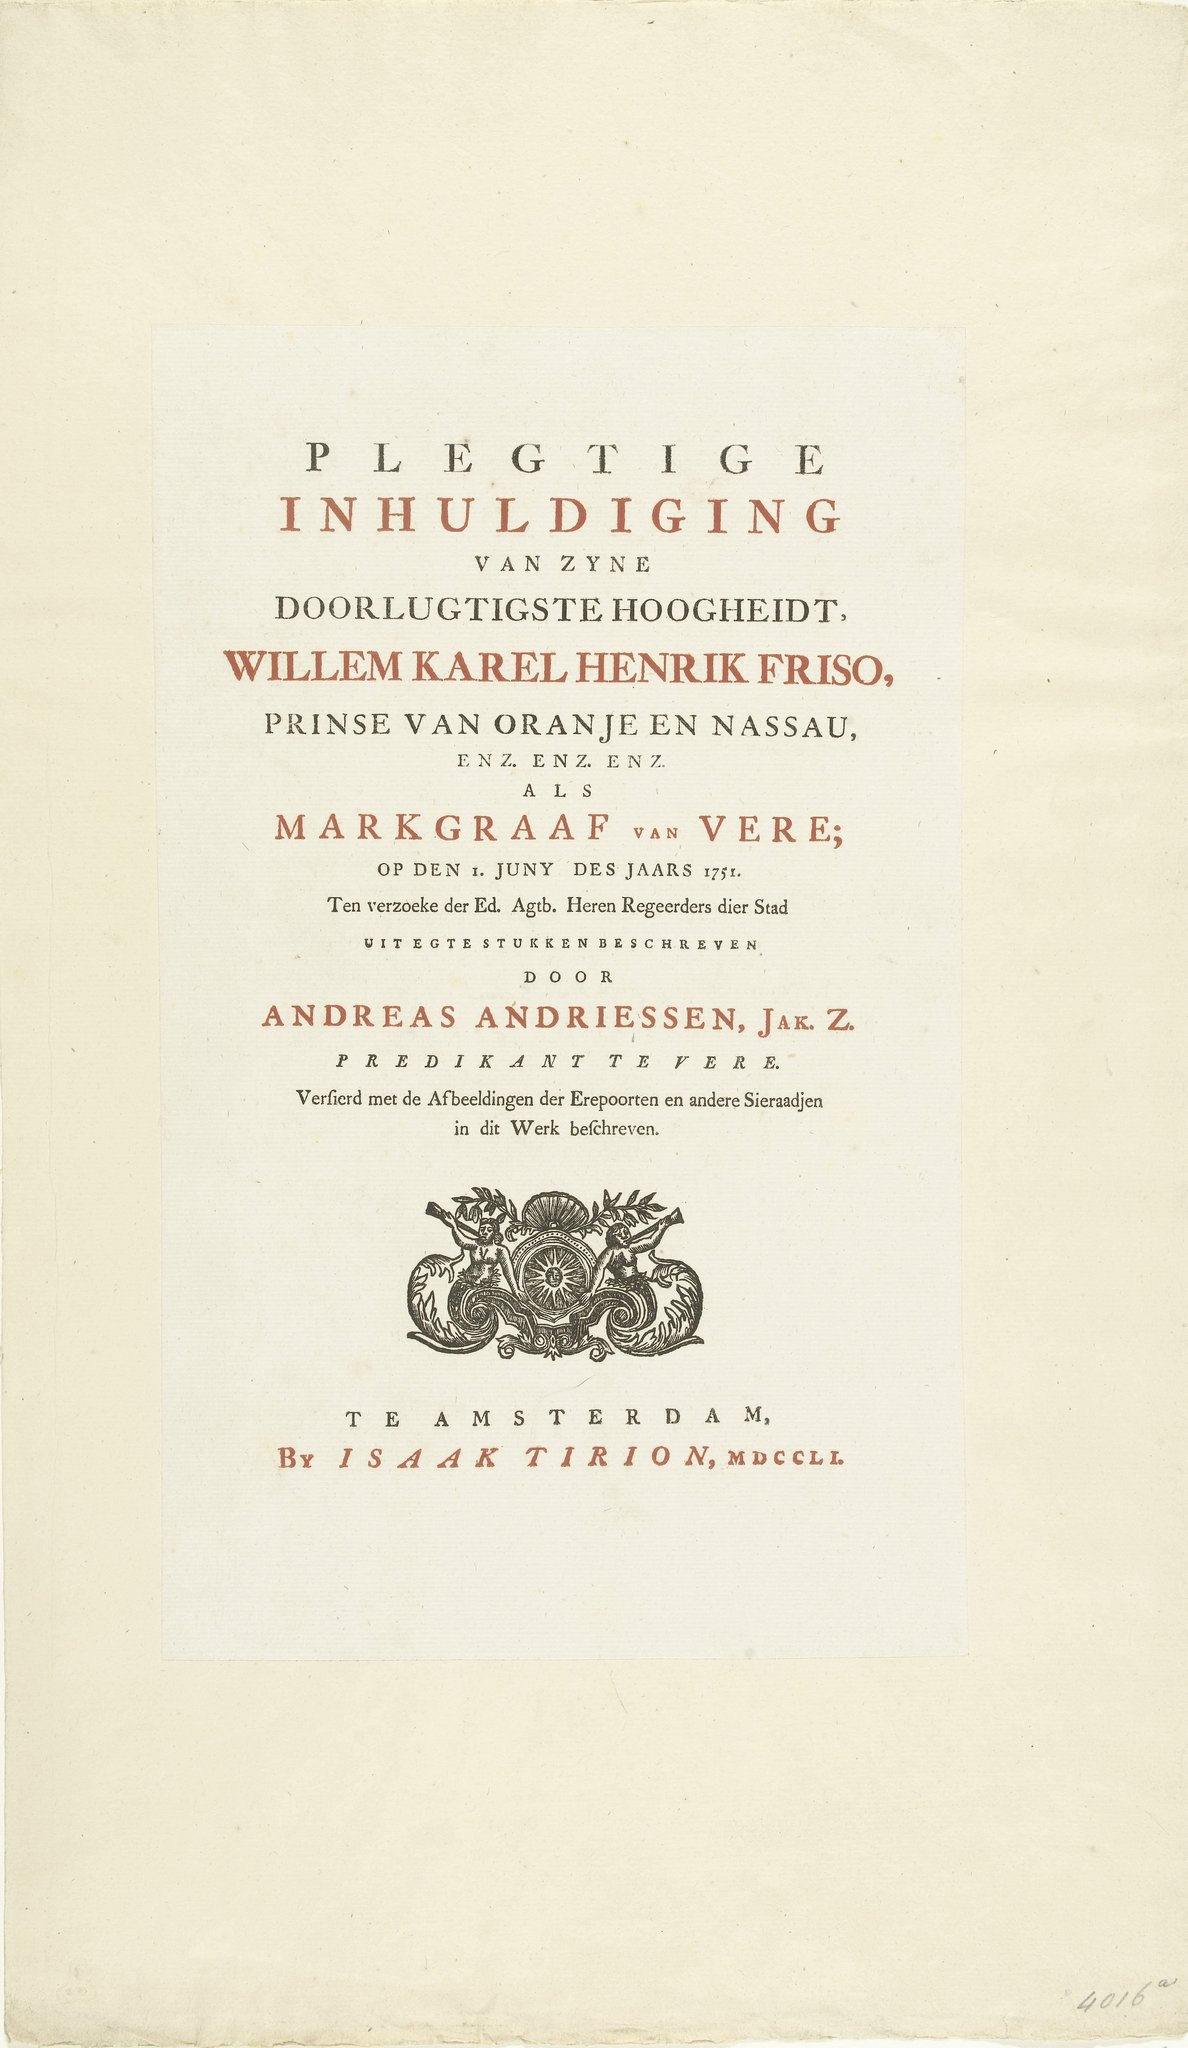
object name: titelblad, titelpagina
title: Titelpagina van Plegtige inhuldiging van zyne doorlugtigste hoogheidt, Willem Karel Henrik Friso (...) als markgraaf van Vere, 1751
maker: isaak tirion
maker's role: publisher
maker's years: 1705-1765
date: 1751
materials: paper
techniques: letterpress printing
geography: amsterdam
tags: willem iv (prins van oranje-nassau), title-page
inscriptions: collector's mark: Lugt 2228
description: Titelpagina van A. Andriessen, Plegtige inhuldiging van zyne doorlugtigste hoogheidt, Willem Karel Henrik Friso ... als markgraaf van Vere, 1751. Onderdeel van de illustraties van de feestelijke inhuldiging van stadhouder Willem IV als markgraaf van Veere op 1 juni 1751. Tekst gedrukt in zwart en rood met onderaan een vignet.